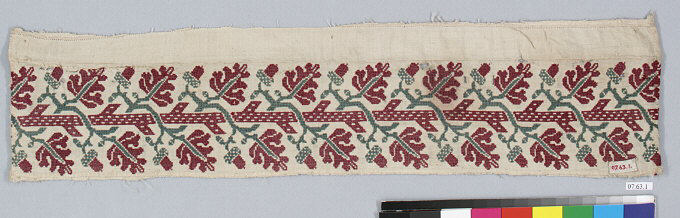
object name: strip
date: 1601-1700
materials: linen, silk